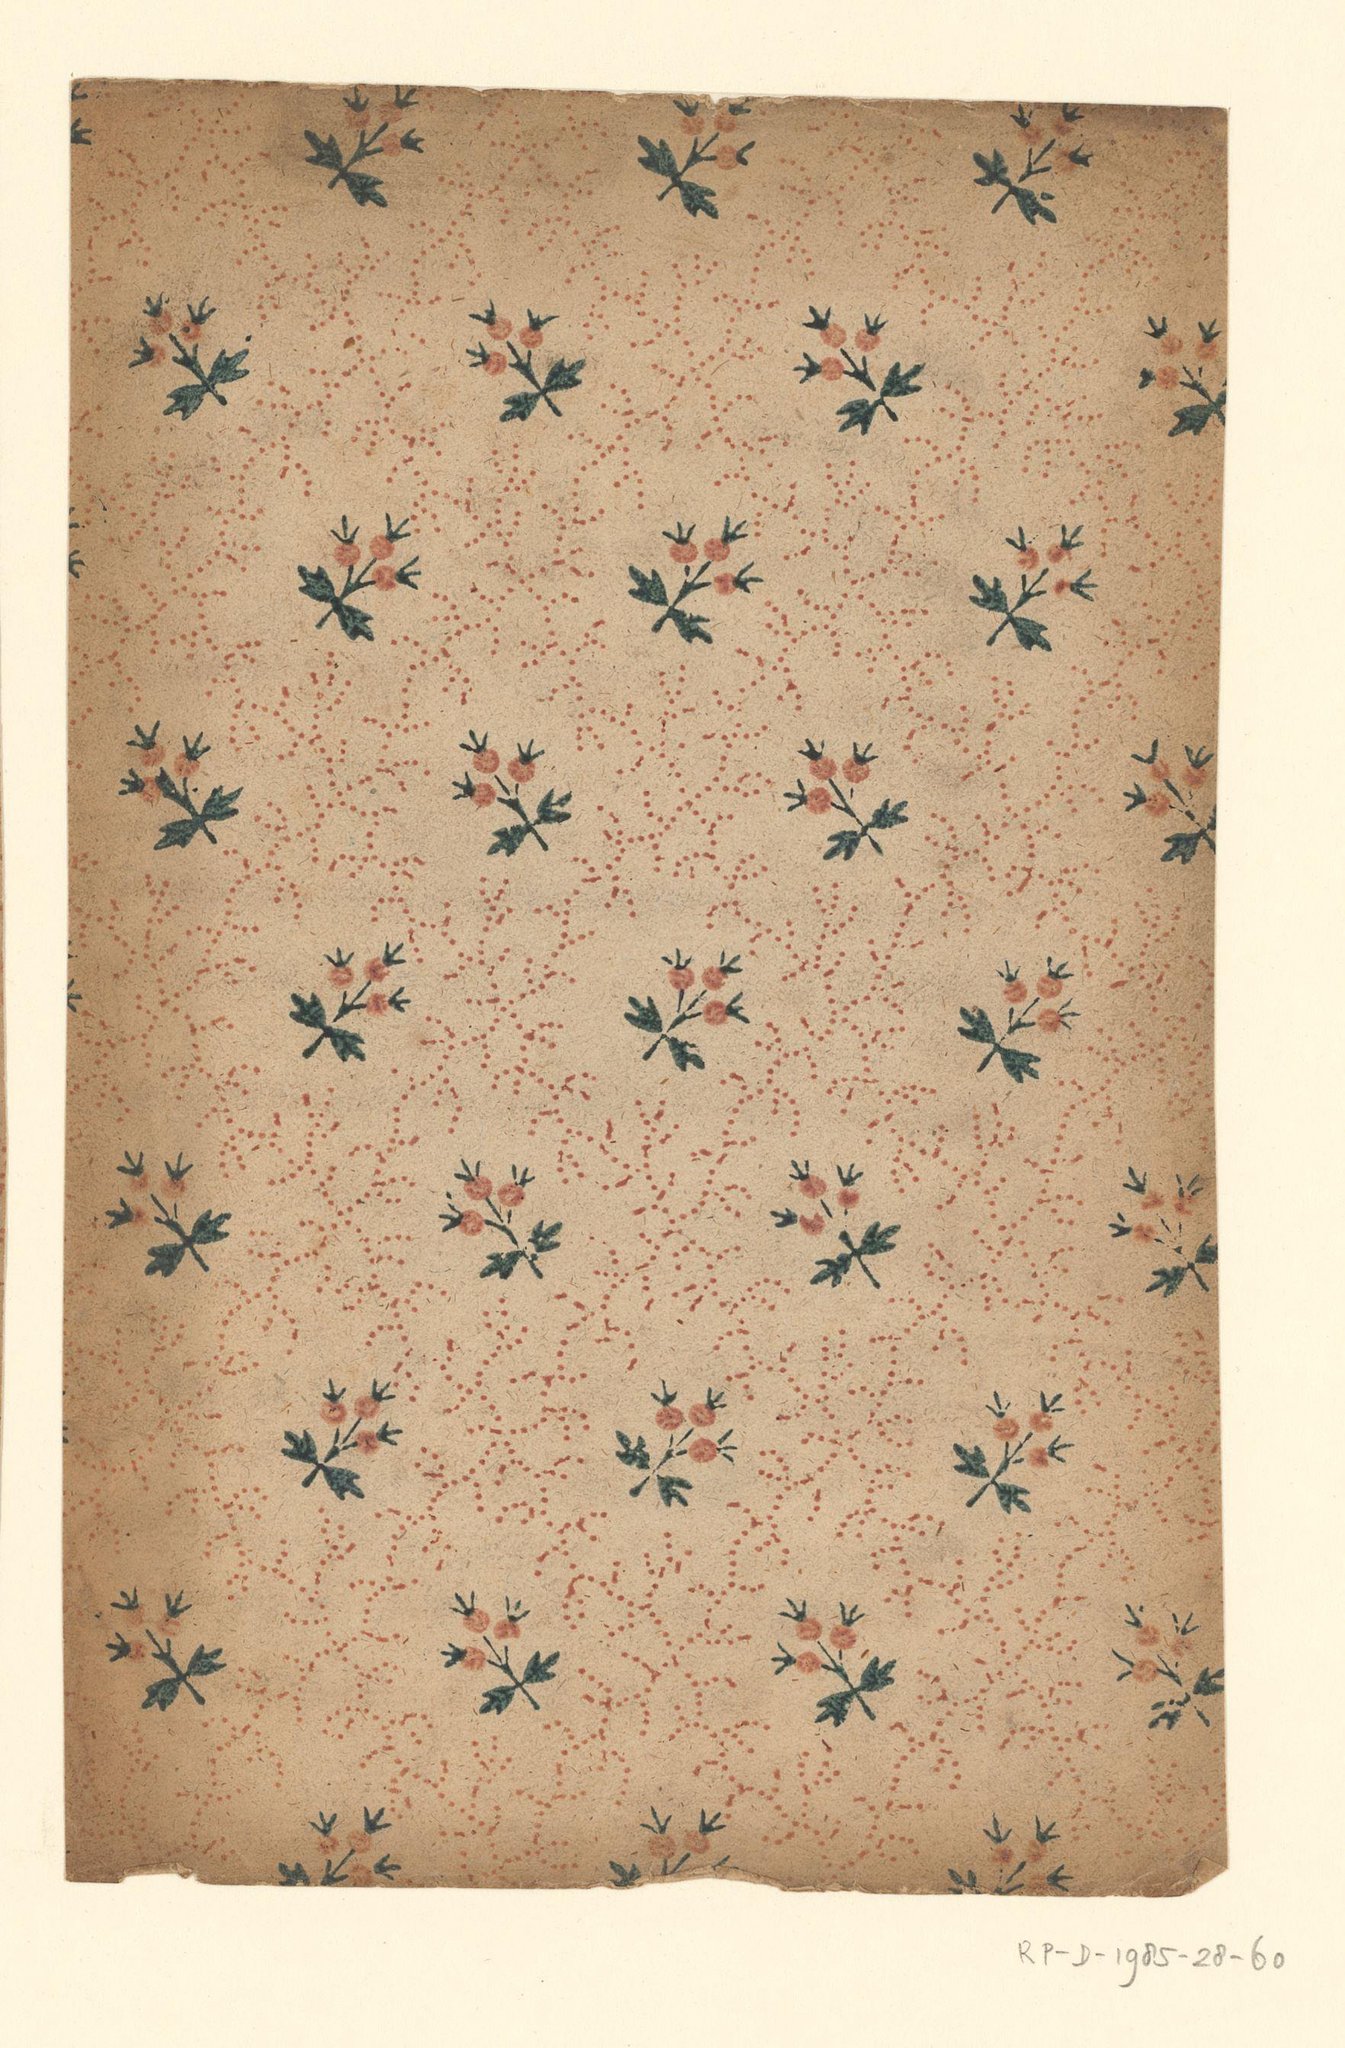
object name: printed paper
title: Blad met strooipatroon van bloemtakje tussen stippenranken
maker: Anonymous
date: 1750-1900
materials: paper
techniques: printing block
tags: ornament derived from plant forms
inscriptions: collector's mark: Lugt 2760, collector's mark: Lugt 2228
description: Blad met strooipatroon van bloemtakje tussen stippenranken. Helft van een omslag.